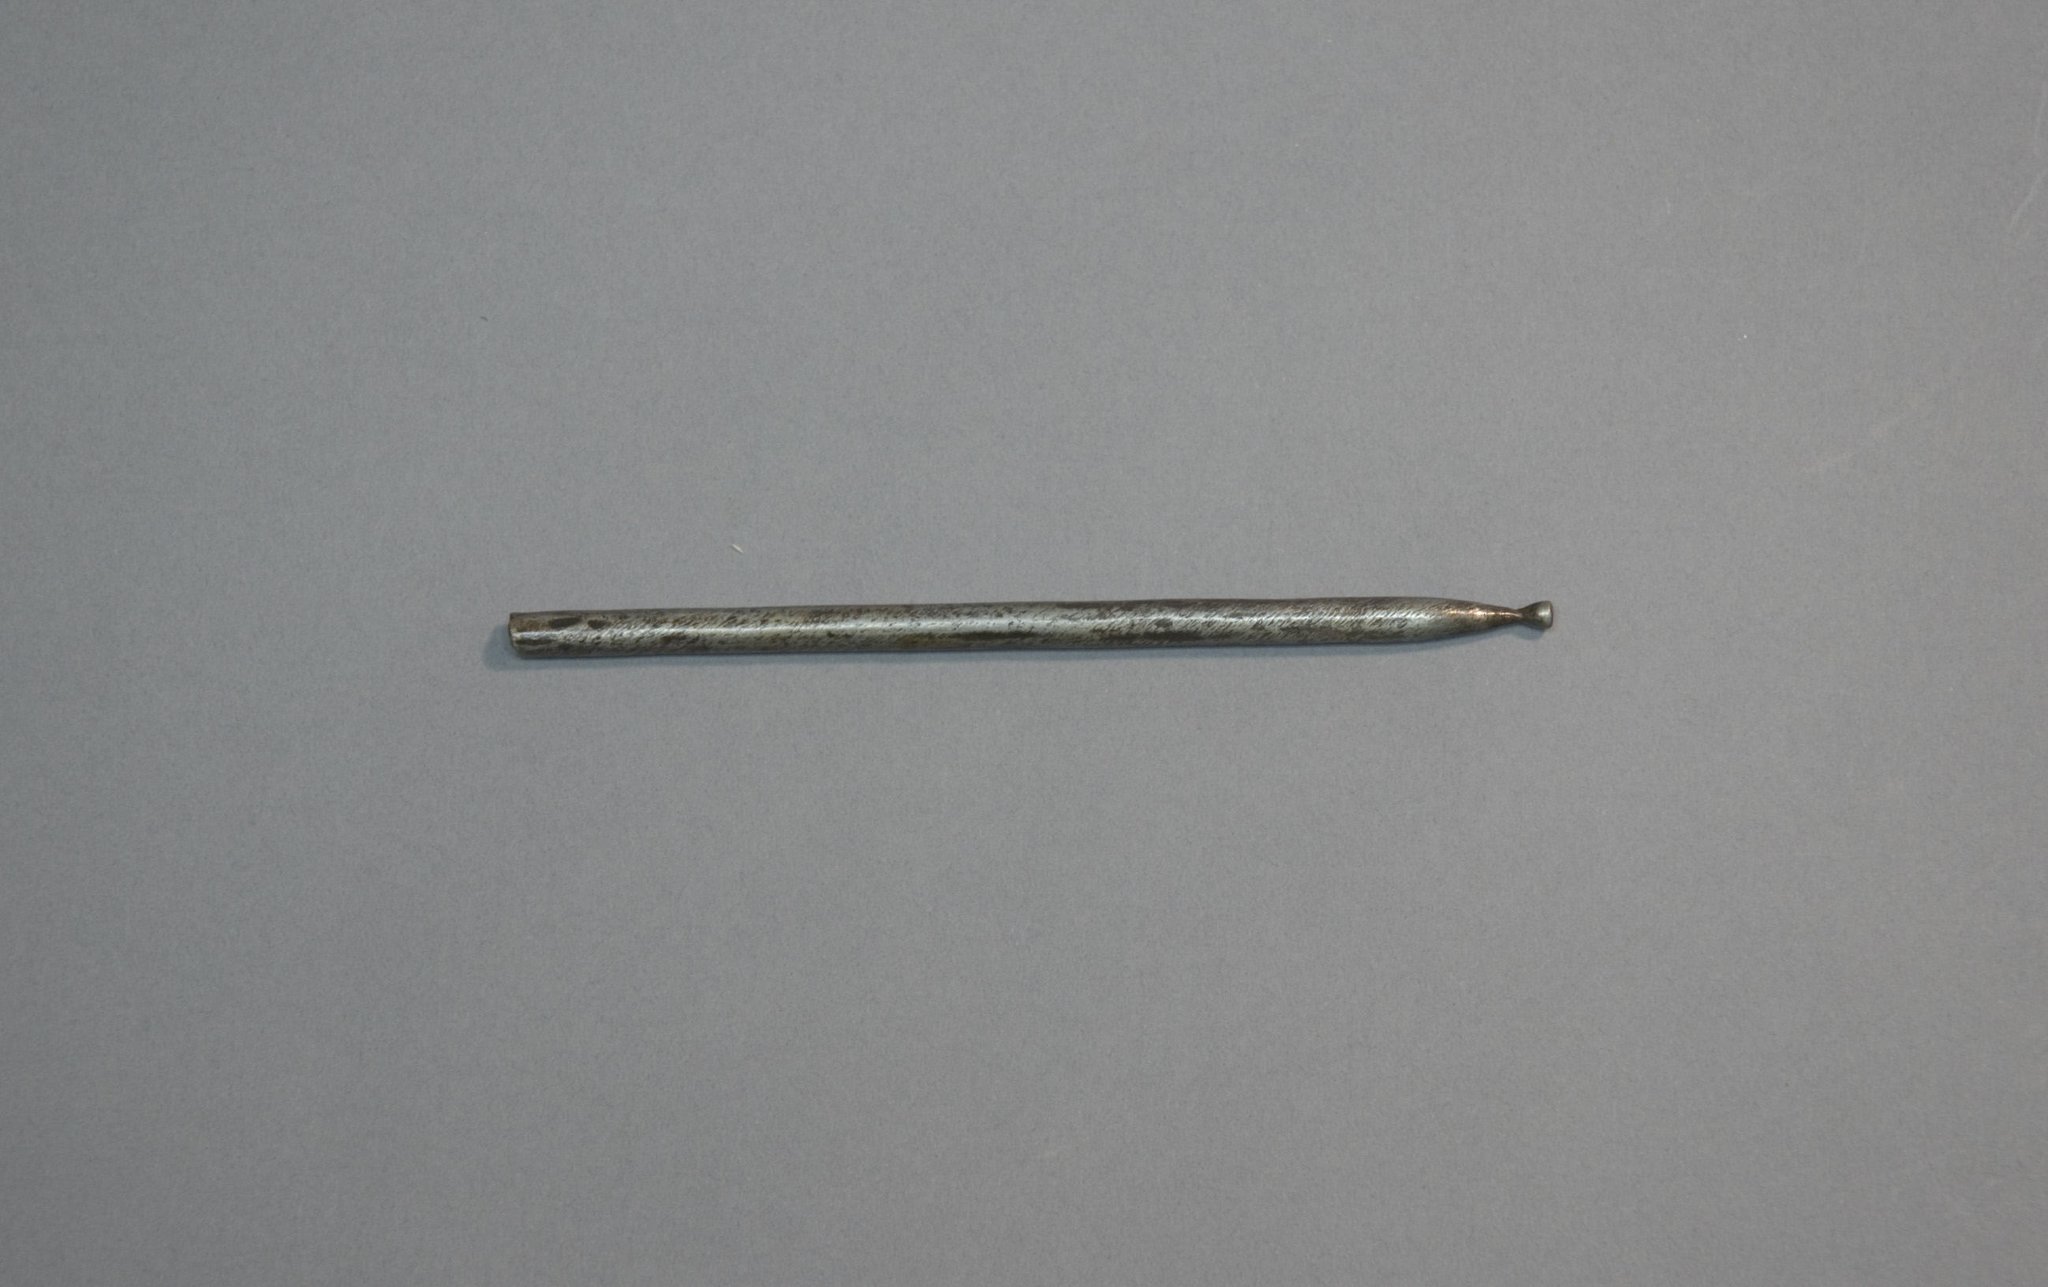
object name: jade carving tool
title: Drill for carving jade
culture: chinese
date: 1901-2000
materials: steel